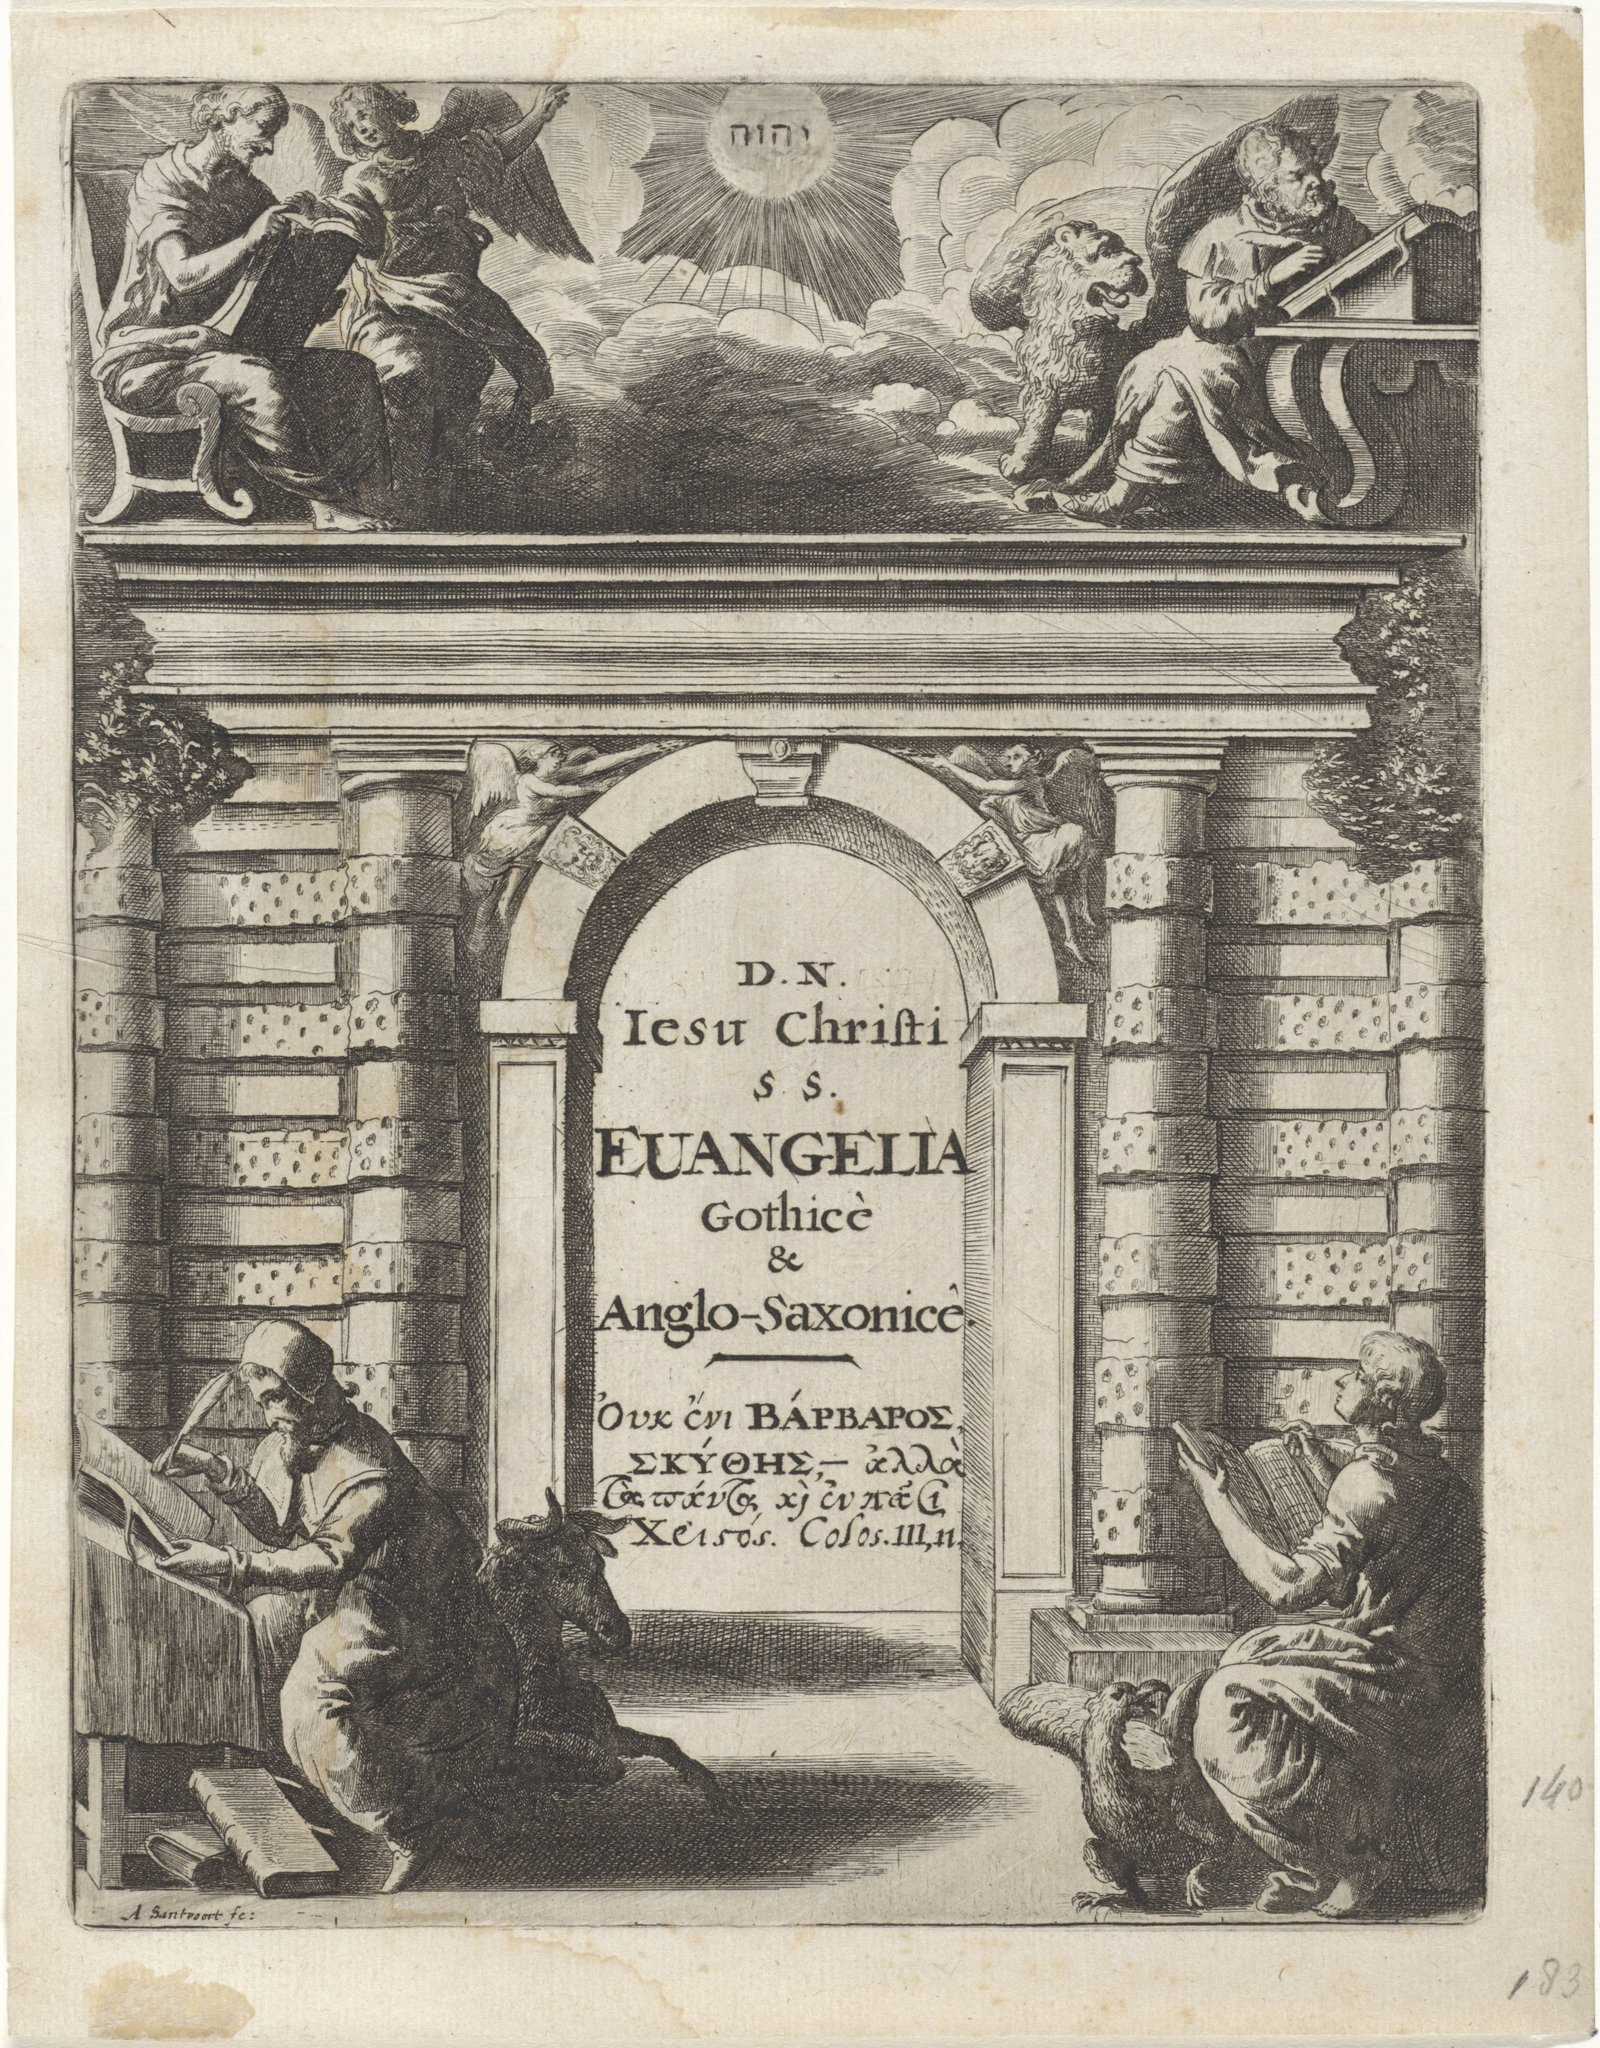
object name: titelblad, titelpagina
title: Titelpagina voor: Junius, Franciscus en Marshall, Thomas. Quatuor D.N. Jesu Christi S.S. Evangelia Gothicè & Anglo-Saxonicè, 1665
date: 1665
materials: paper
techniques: etching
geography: dordrecht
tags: rustication ~ surface decorations (architecture), title-page, gate, entrance, the evangelists writing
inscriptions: collector's mark: Lugt 2228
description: In het midden een toegangspoort, aangezet met rustica. Linksboven zit Matteüs met een opengeslagen boek naast een engel. Rechts Marcus schrijvend aan een tafel met een gevleugelde leeuw. Linksonder zit Lucas aan een schrijftafel met naast hem een os en rechtsonder schrijft Johannes in een opengeslagen boek, terwijl hij omhoog kijkt. Voor hem zit een adelaar. Onder de titel van het boek een vierregelige, oud-Griekse tekst.